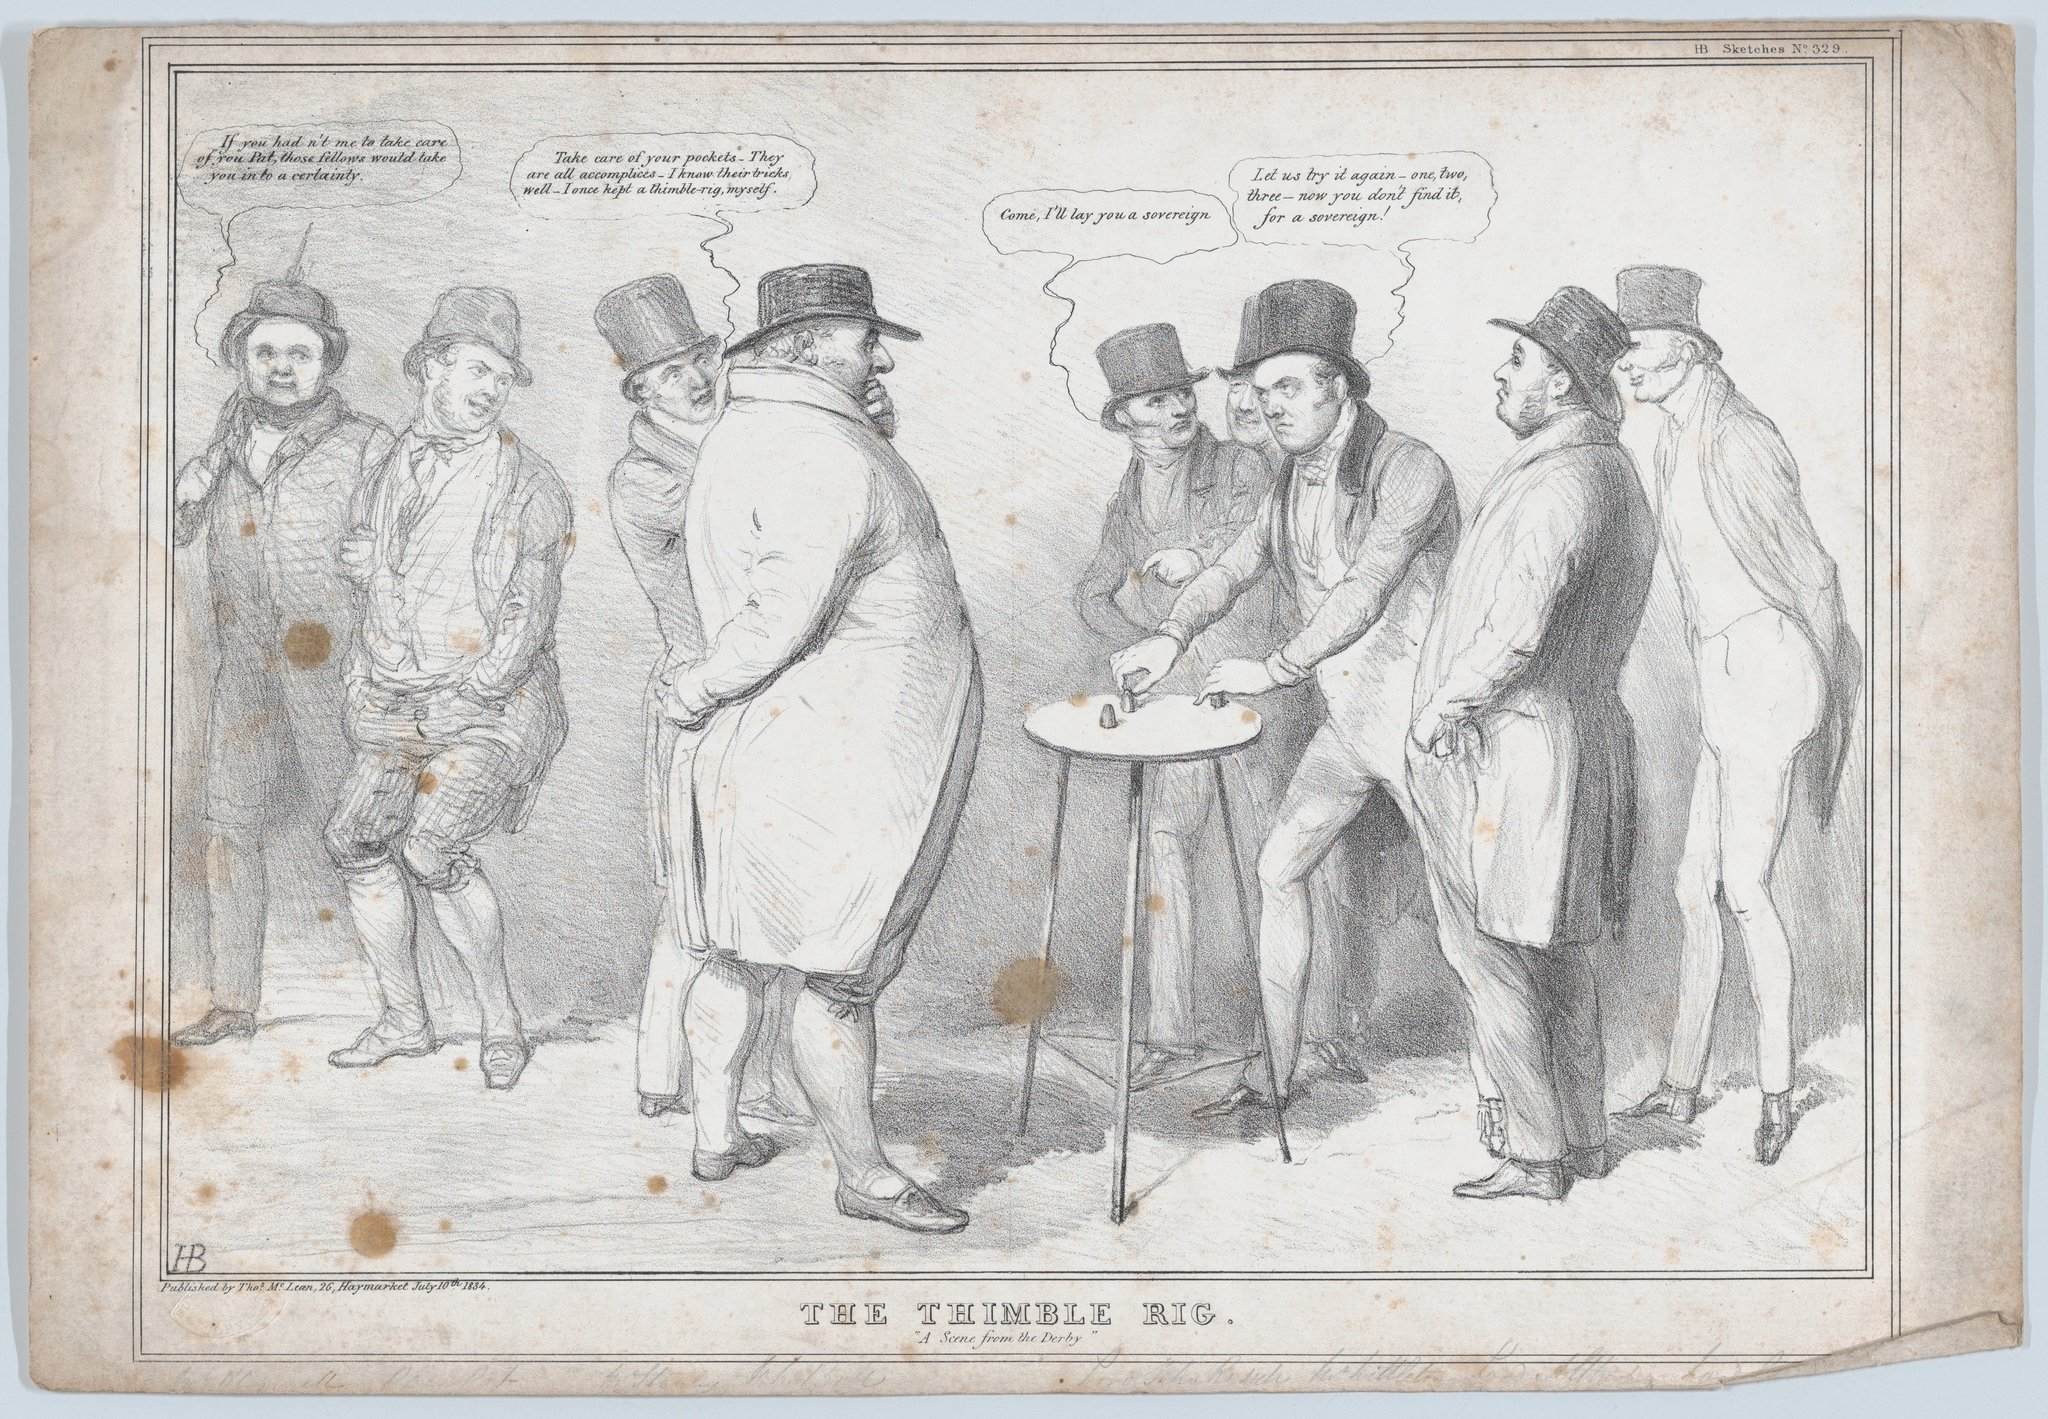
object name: print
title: The Thimble Rig: "A Scene from the Derby"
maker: john doyle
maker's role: artist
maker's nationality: irish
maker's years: 1797-1868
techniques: lithograph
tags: satire,men,politics